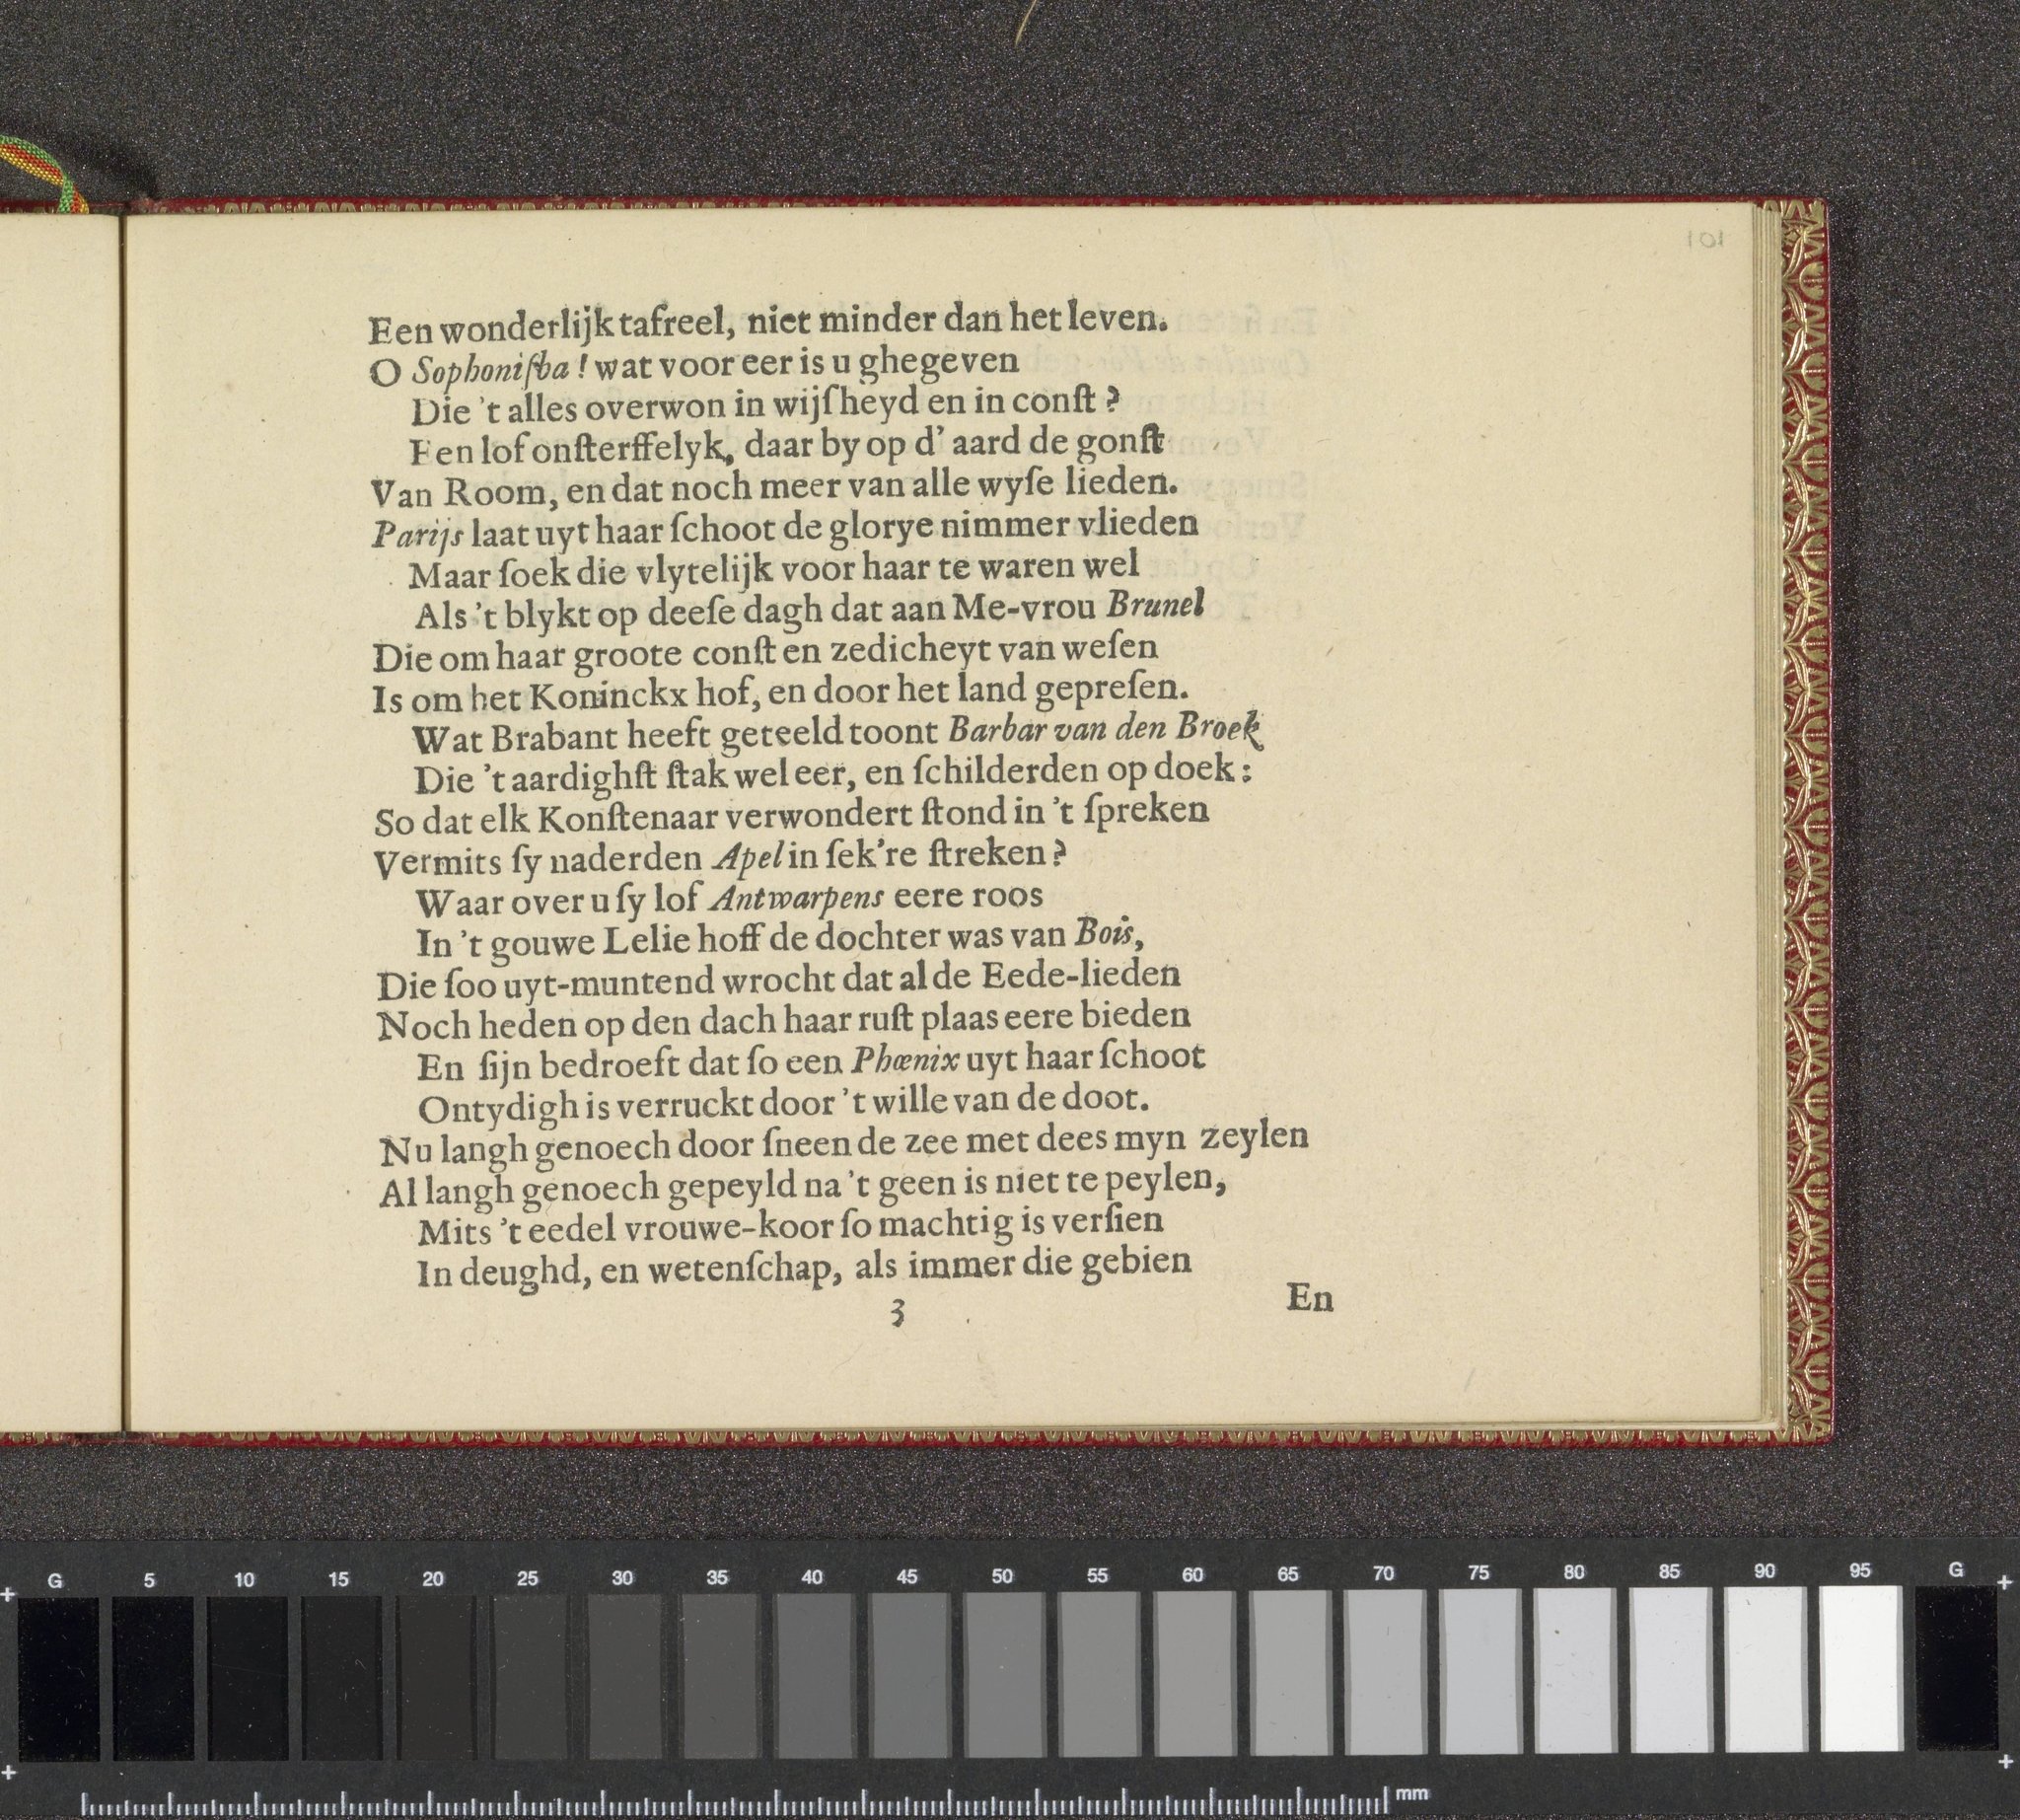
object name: album leaf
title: Aen de Nimphies vanden Amstel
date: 1640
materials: paper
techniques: letterpress printing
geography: amsterdam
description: Nederlandstalig gedicht op de Nimfen van de Amstel op elf pagina's: pagina 10. Het blad maakt deel uit van een album.